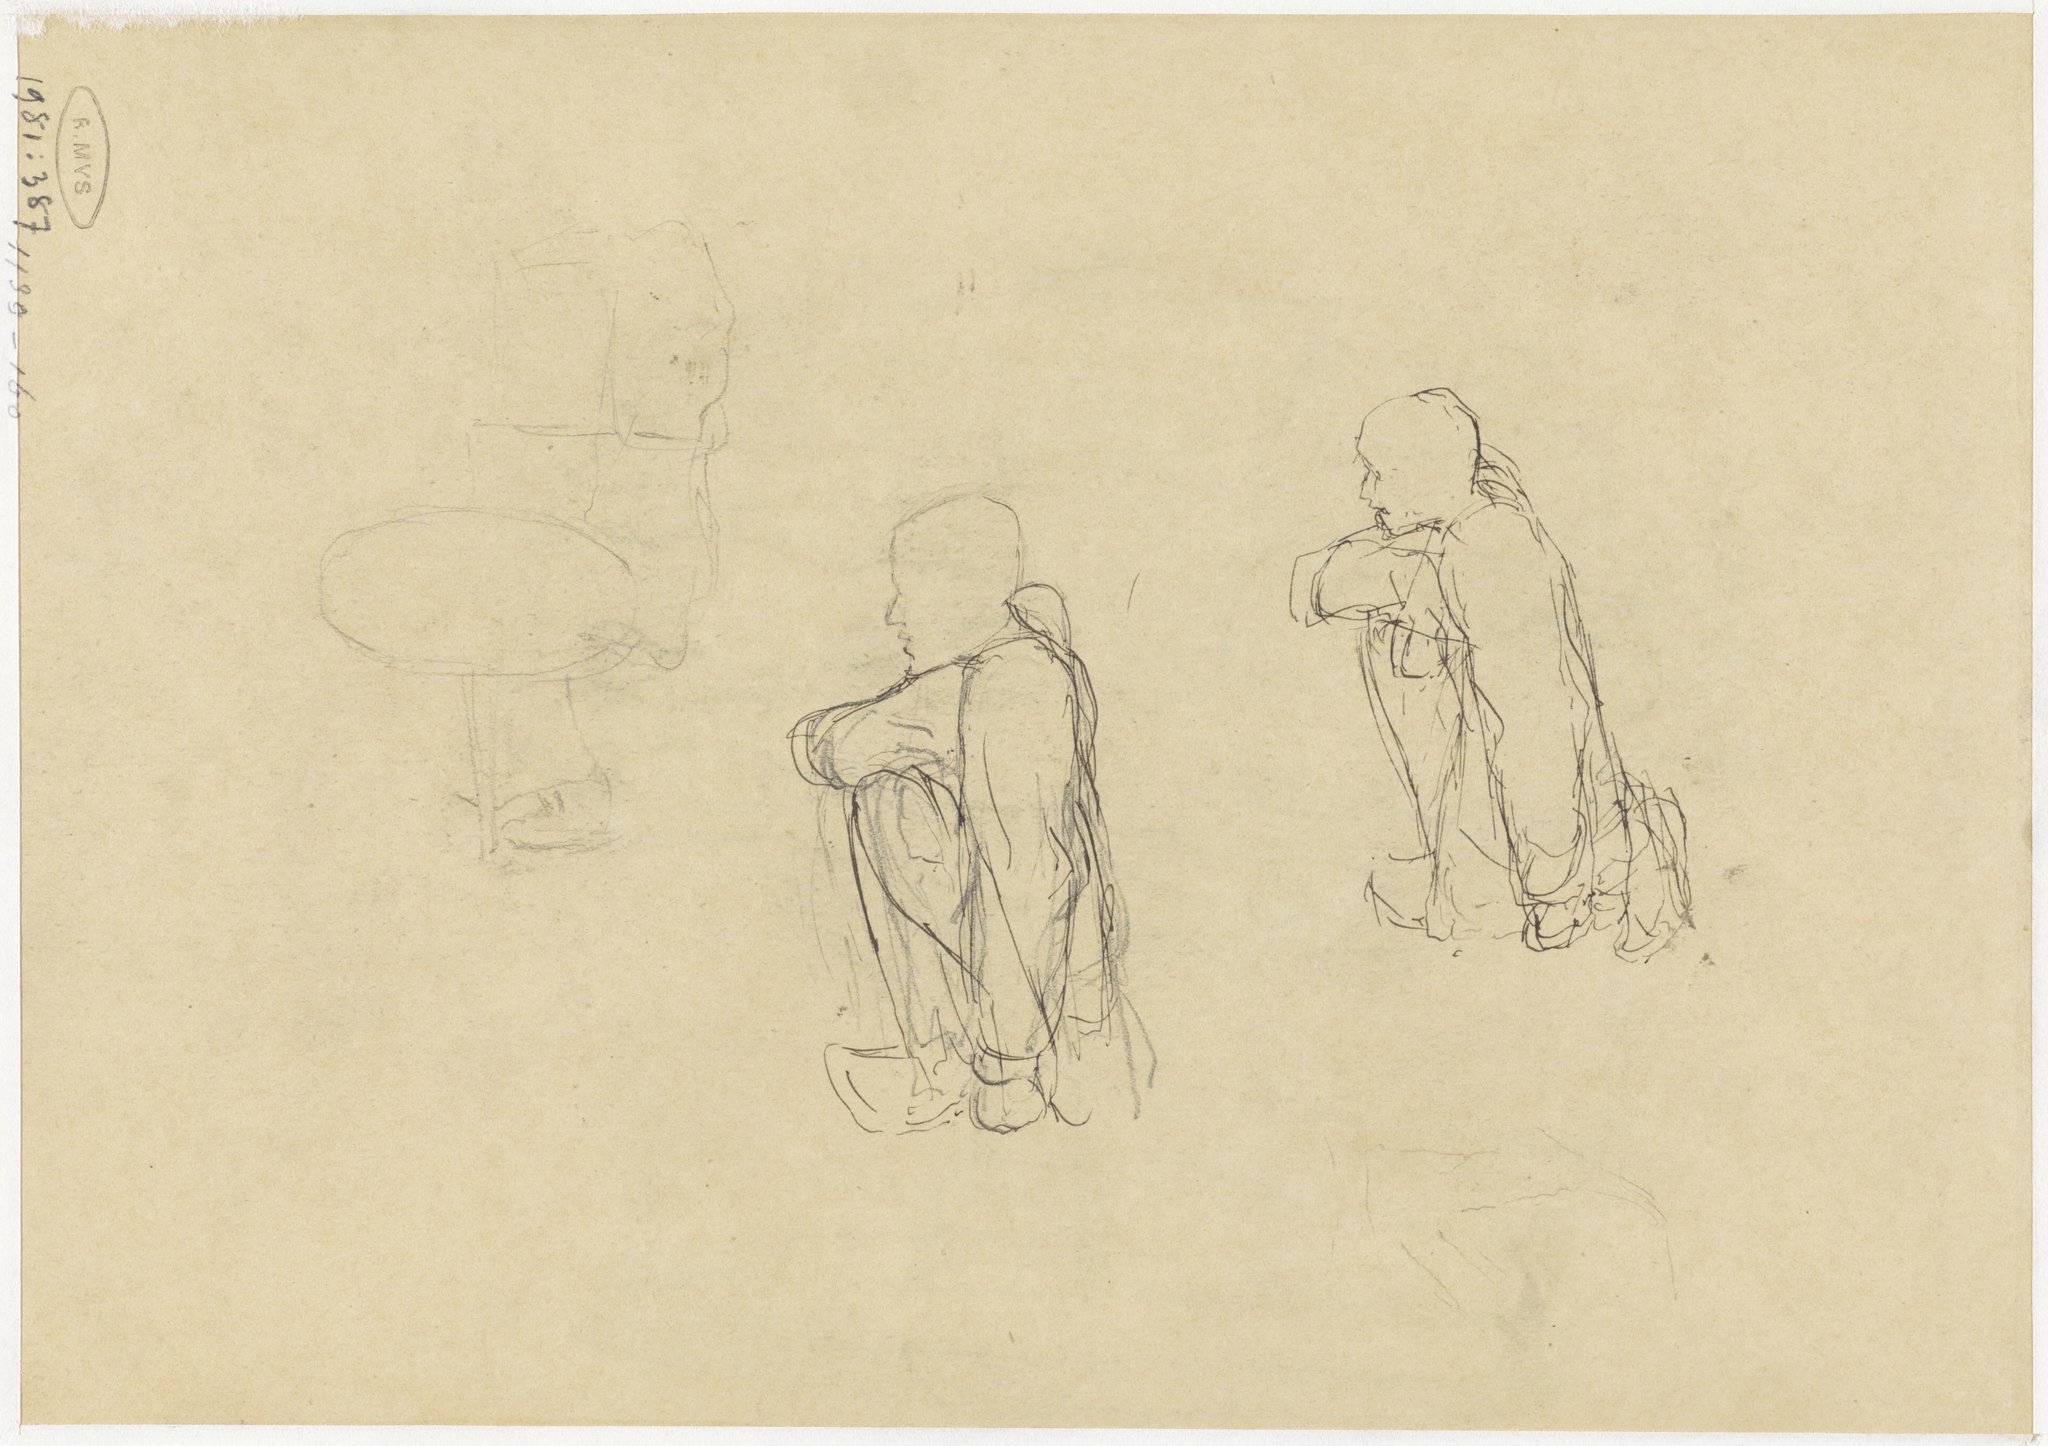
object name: drawing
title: Twee schetsen van een hurkend figuur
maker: jozef israëls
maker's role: draughtsman, painter, print maker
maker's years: 1824-1911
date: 1834-1911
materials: ink, paper, pencil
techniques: pen